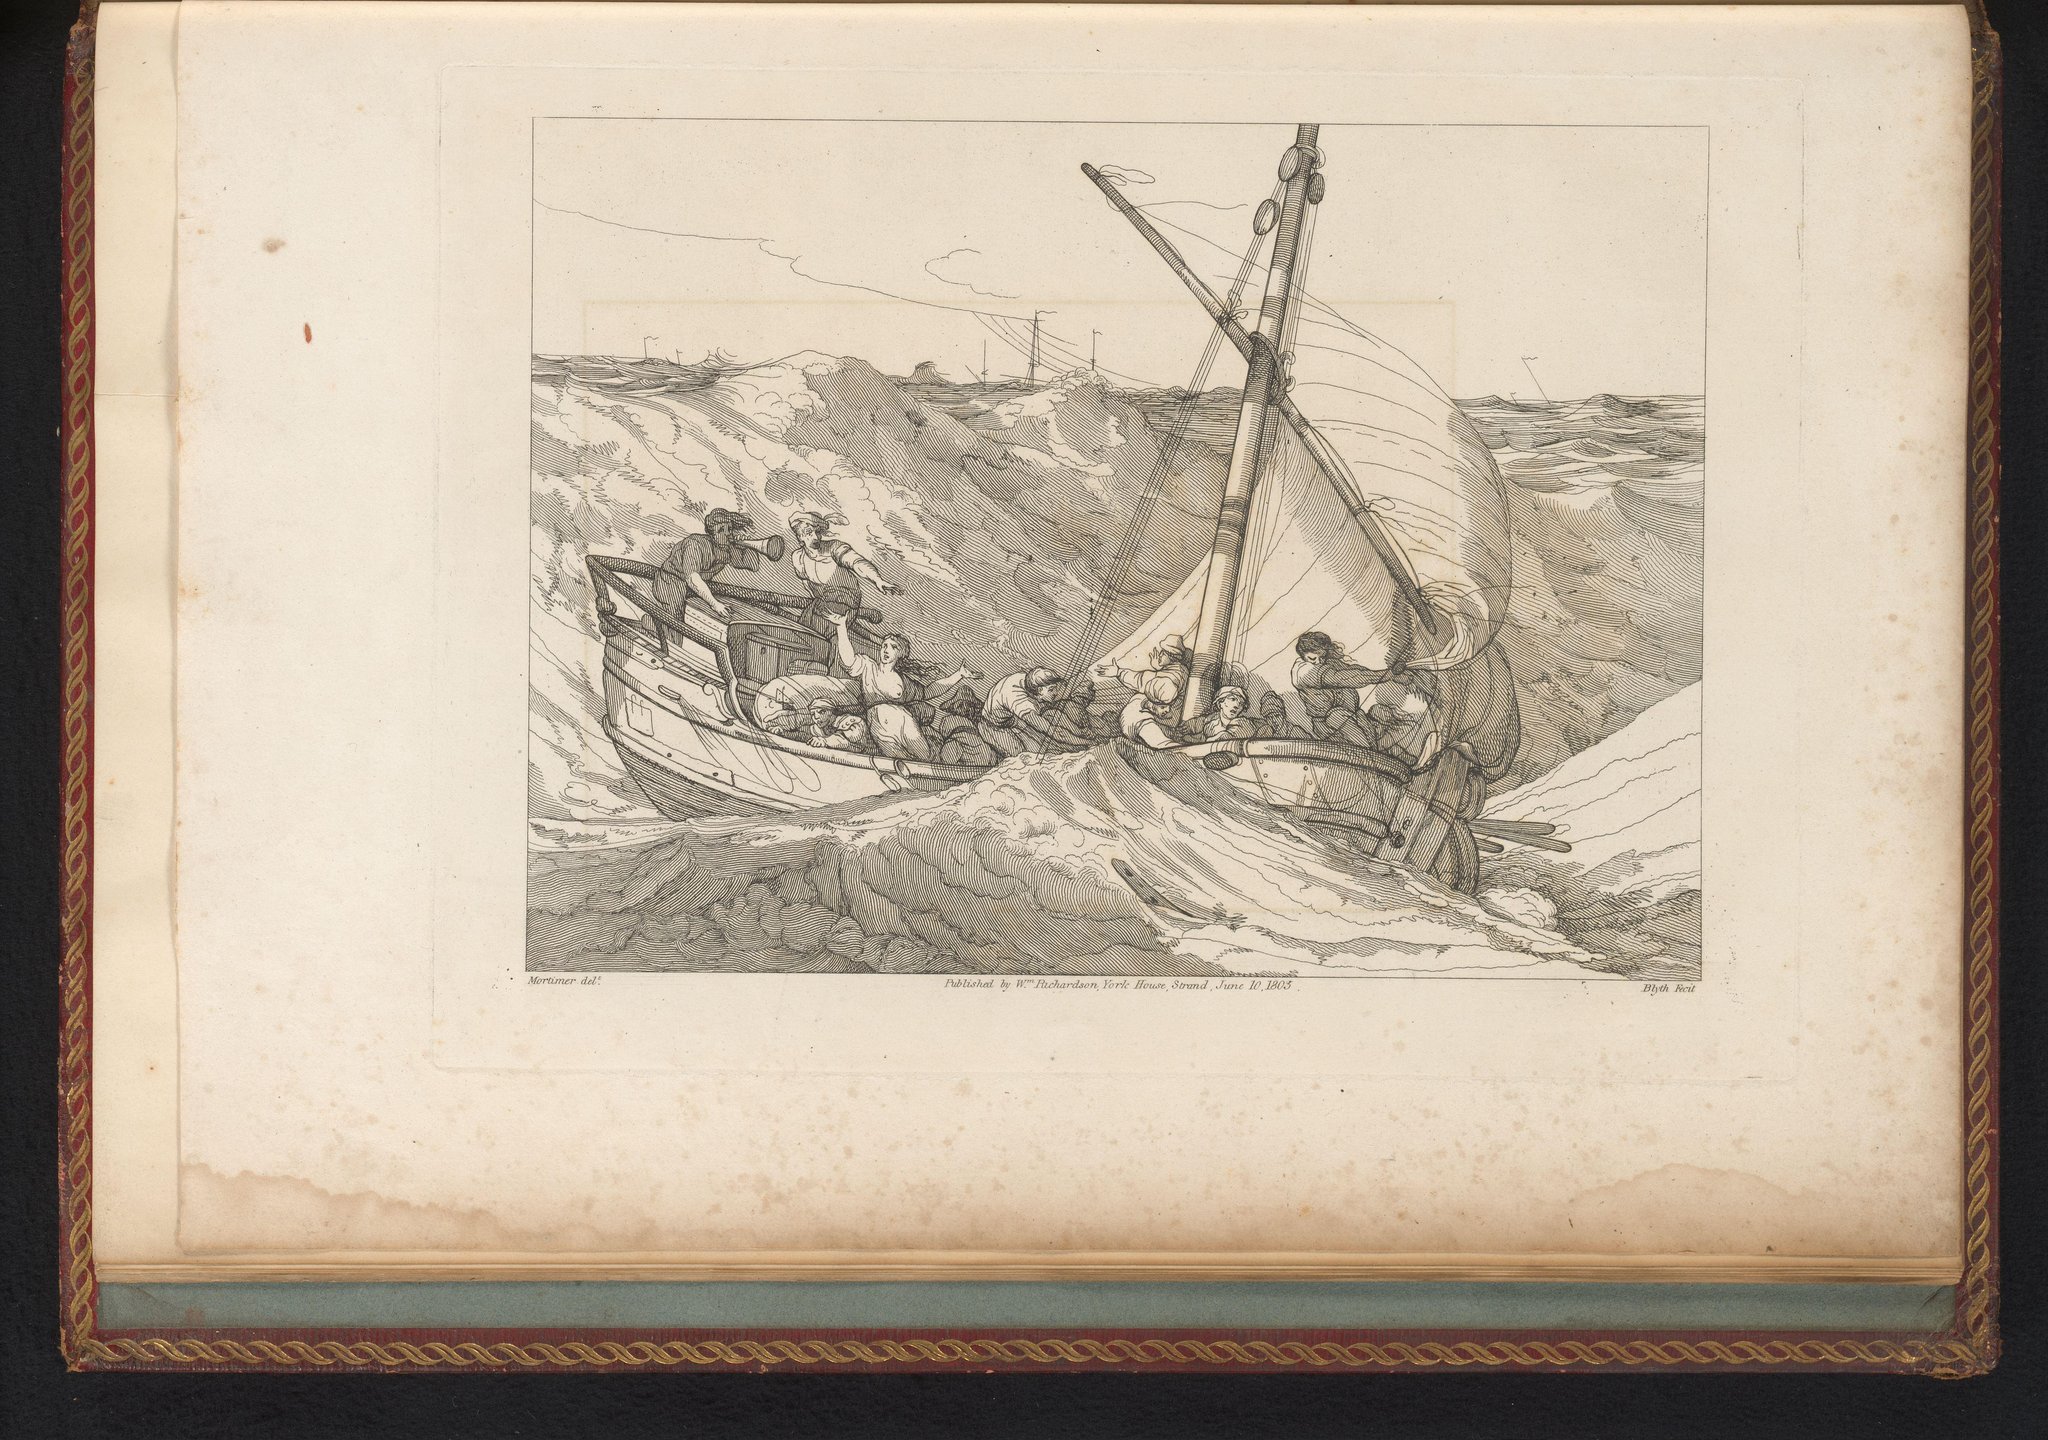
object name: print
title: Vissersboot in de golven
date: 1805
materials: paper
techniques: etching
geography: london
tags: sailing-ship, sailing-boat, storm at sea, fisherman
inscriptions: date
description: De samensteller heeft deze prent in het album geplakt als illustratie bij: Pilkington, Matthew en Johann Heinrich Füssli. A dictionary of painters, from the revival of the art to the present period. 4 dln. Londen: John Crowder, 1805, dl. 2, p. 350.